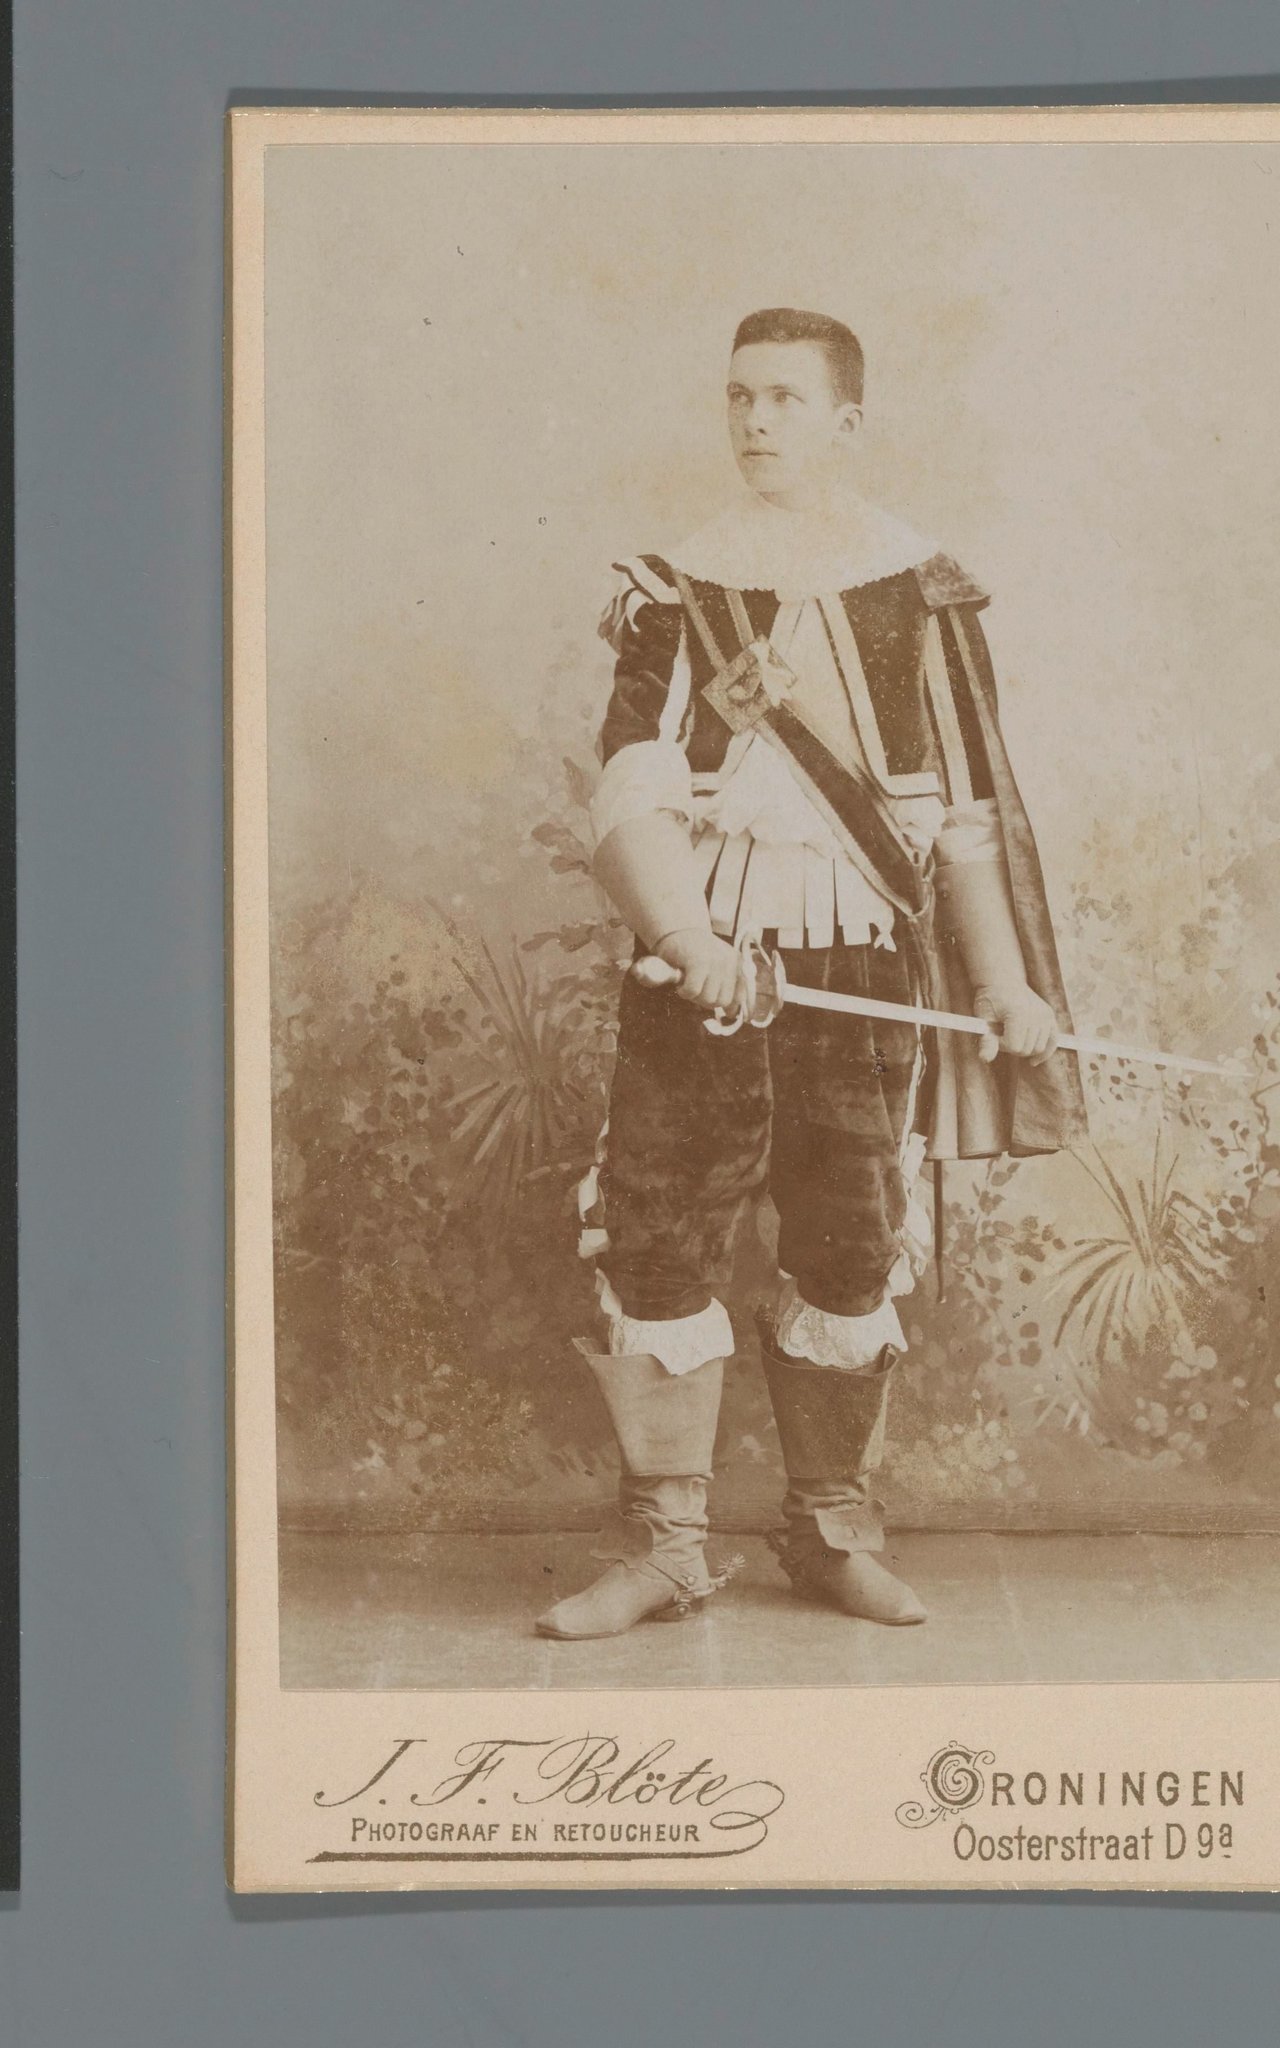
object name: photograph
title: Portret van een onbekende Groningse student in maskeradekostuum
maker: jan frederik blöte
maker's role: fotograaf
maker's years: 1865-1956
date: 1896-1900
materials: paper, cardboard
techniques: collodion silver print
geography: groningen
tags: students' pageant, costumes used in pageants, anonymous historical person portrayed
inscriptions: inscription: ‘J.F. Blöte/ Photograaf en retoucheur/ Groningen/ Oosterstraat D9a’